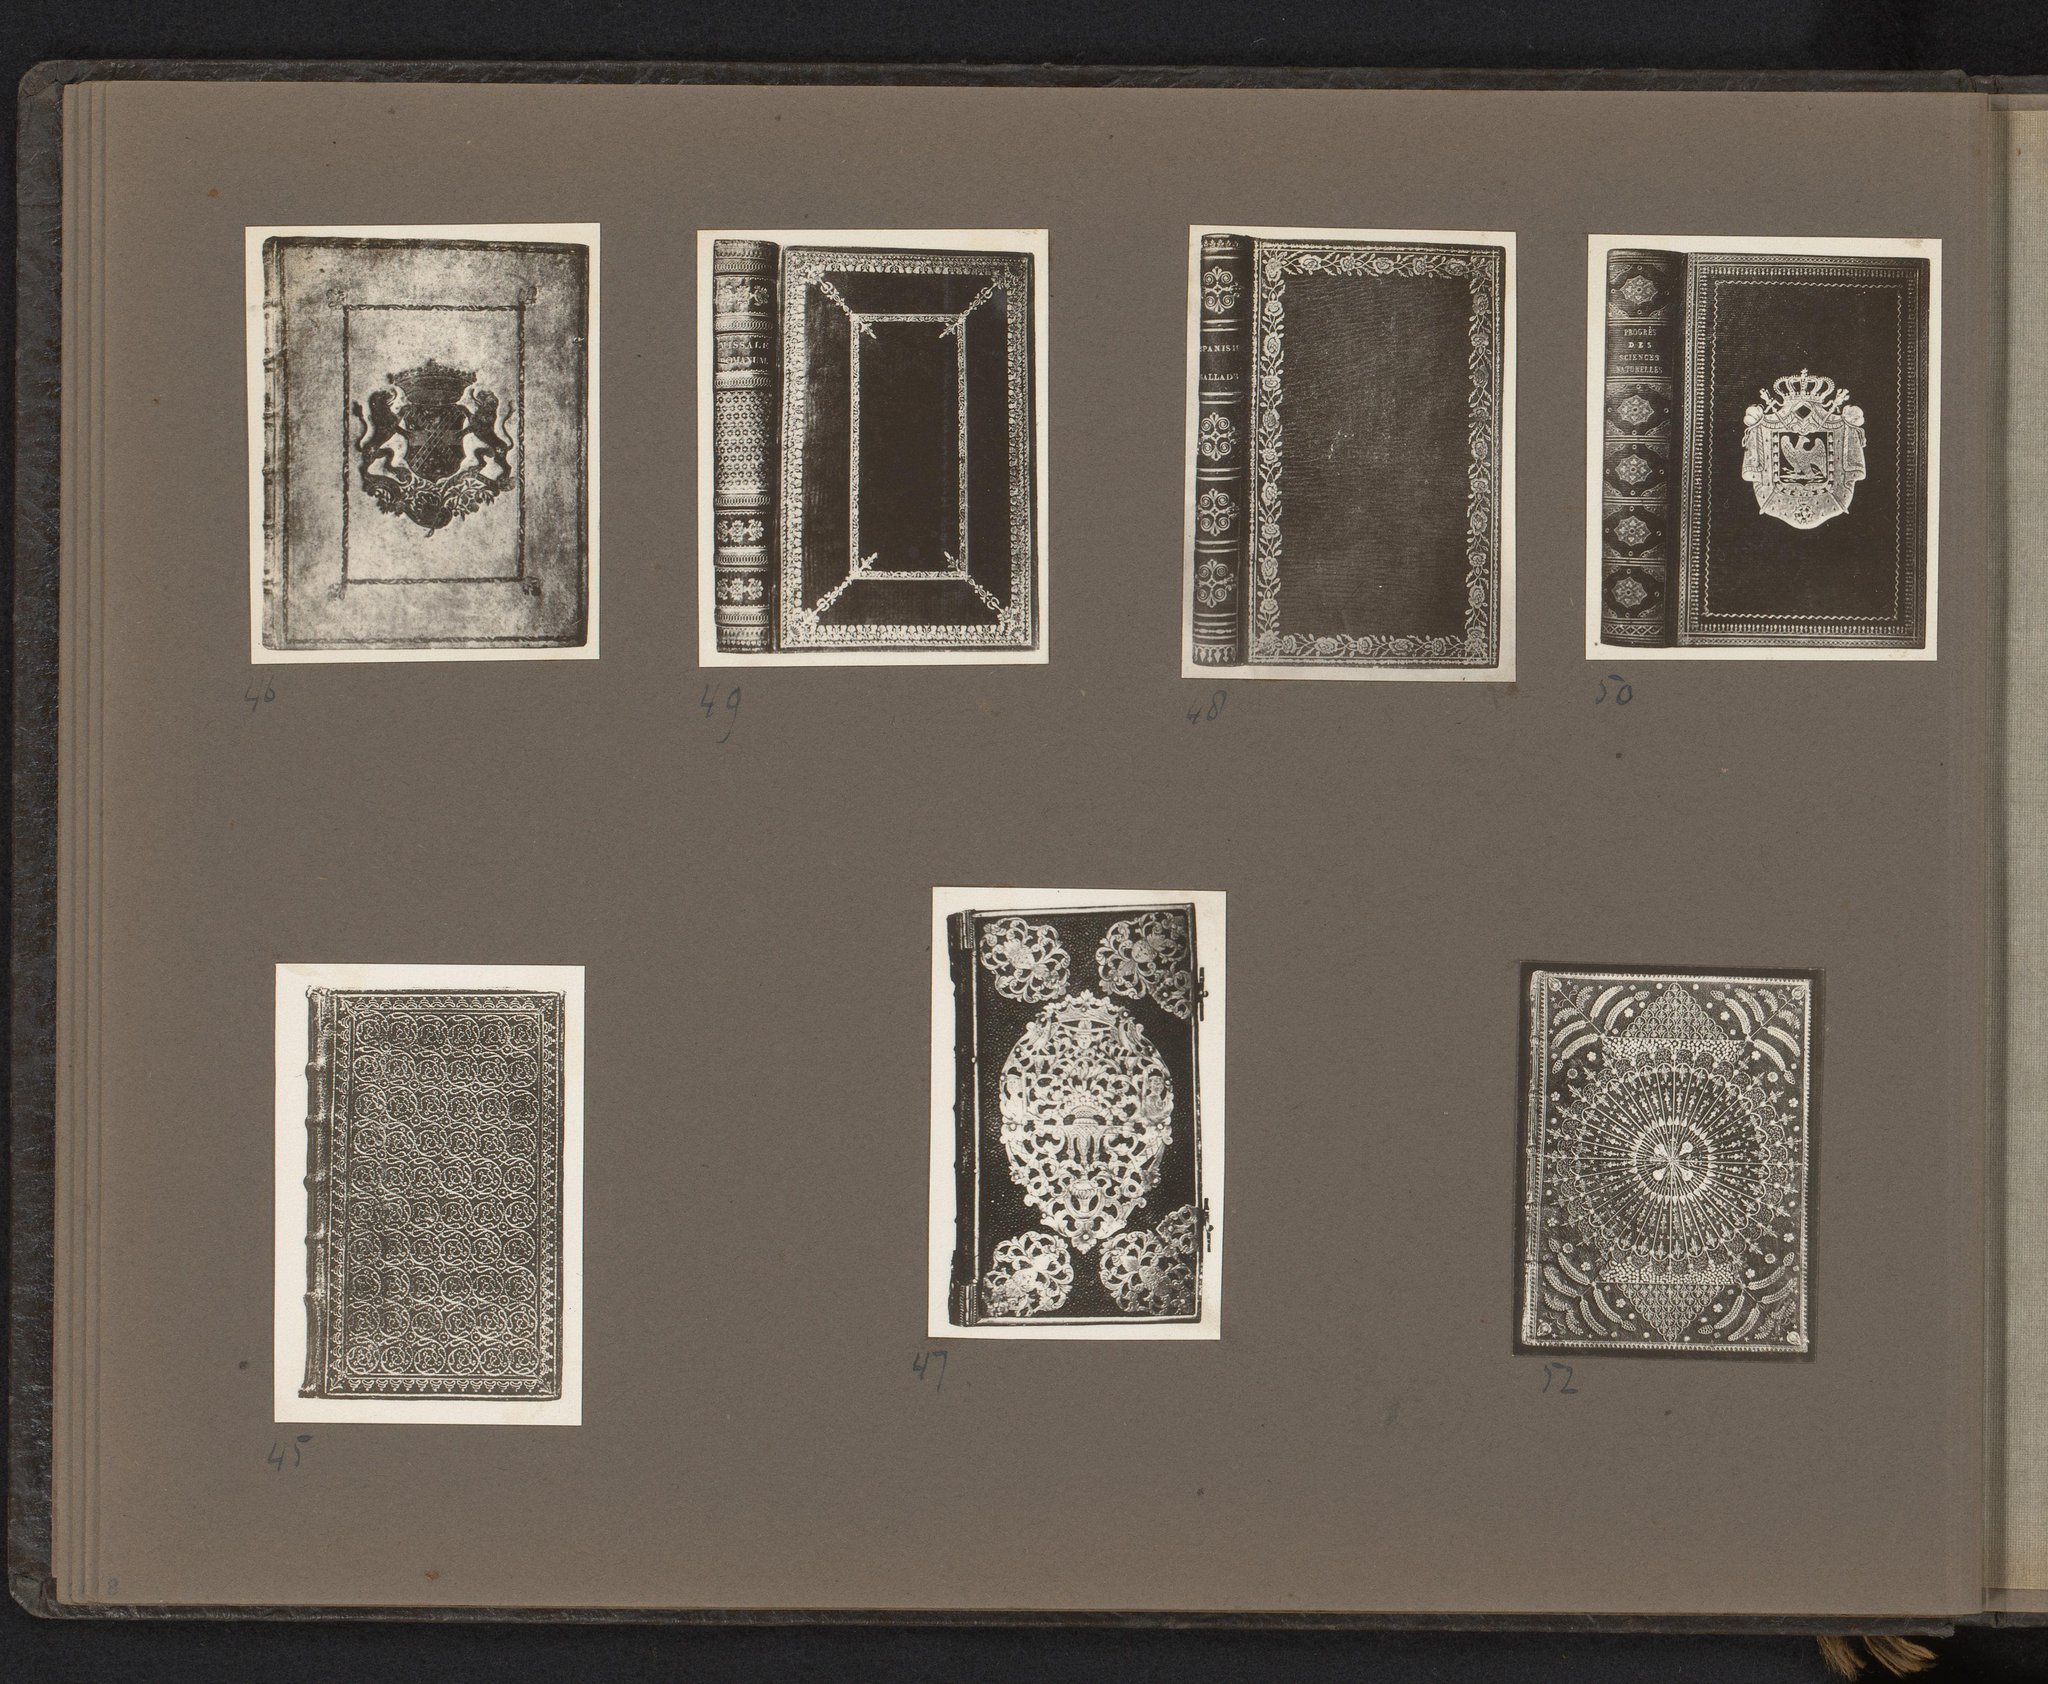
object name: photograph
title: Zeven boekbanden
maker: Anonymous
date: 1920-1940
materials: paper, photographic support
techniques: gelatin silver print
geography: netherlands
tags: book-cover, binding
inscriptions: number: ‘46 - 49 - 48 - 50/ 45 - 47 - 52’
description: Deze foto's maken deel uit van een album.